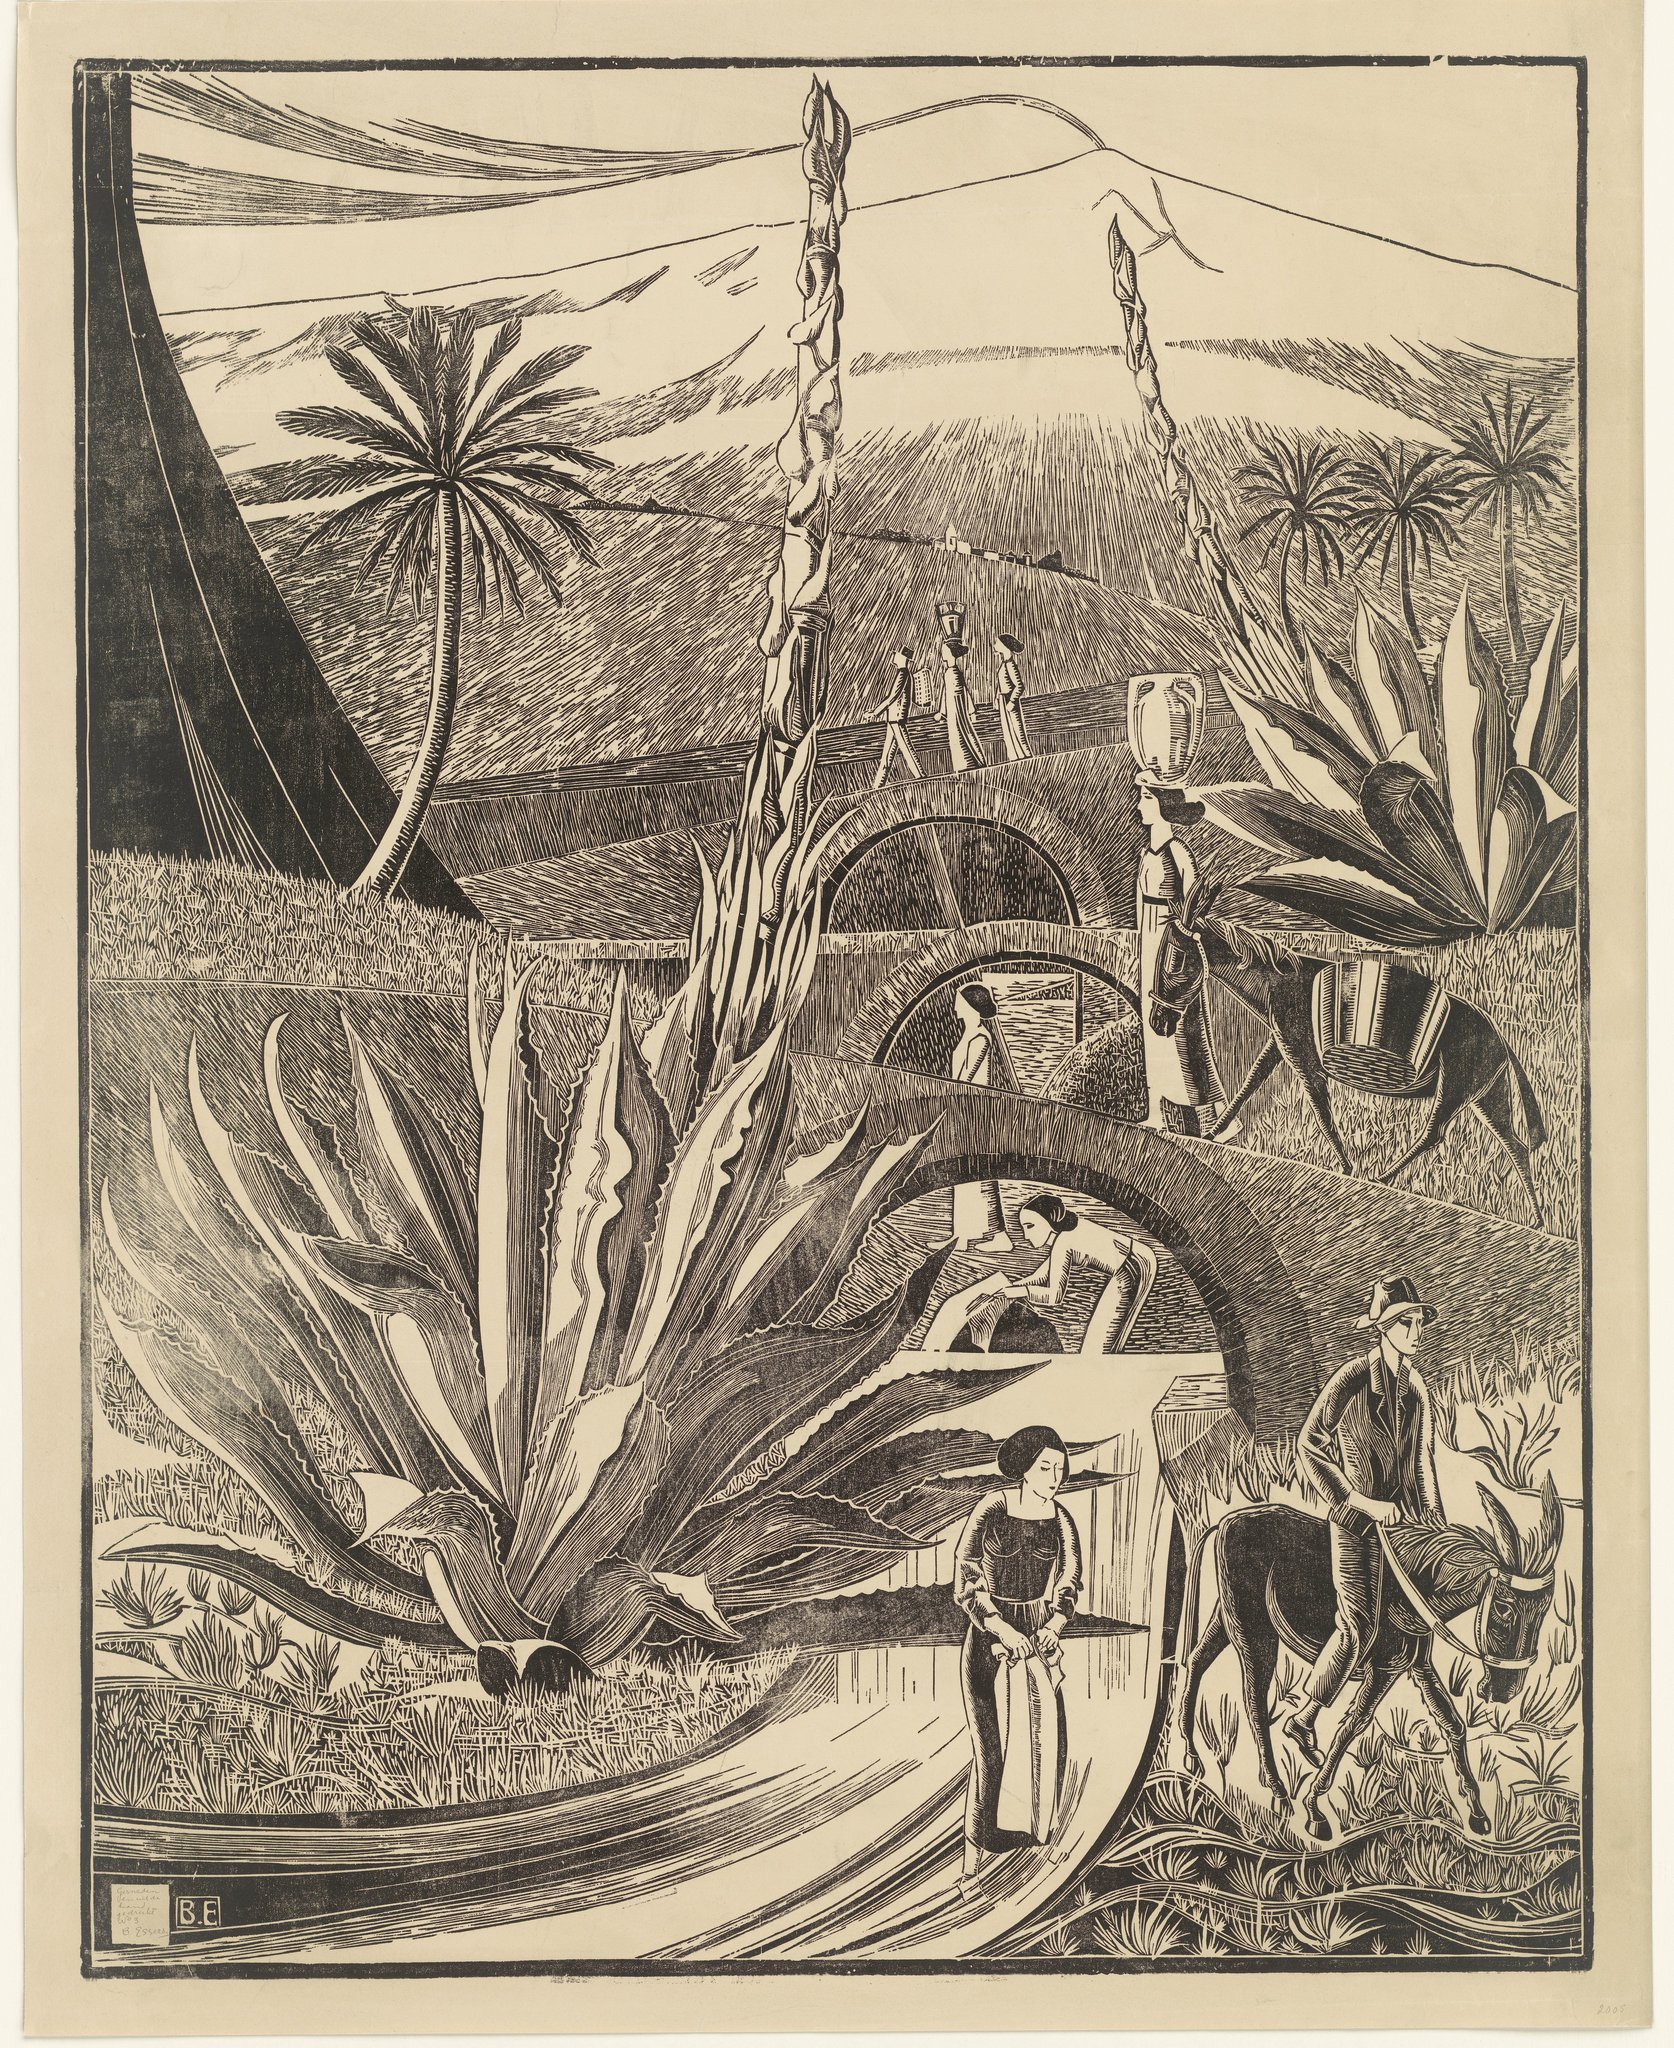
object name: print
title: Groot landschap met palmbomen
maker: bernard essers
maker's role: print maker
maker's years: 1893-1945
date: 1903-1945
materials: paper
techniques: woodcut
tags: ass, donkey, landscape with bridge, viaduct or aqueduct, carrying something in basket, bag, rucksack, etc.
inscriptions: collector's mark: Lugt 2228, inscription: ‘gesneden en uit de hand gedrukt No. 3 B. Essers’